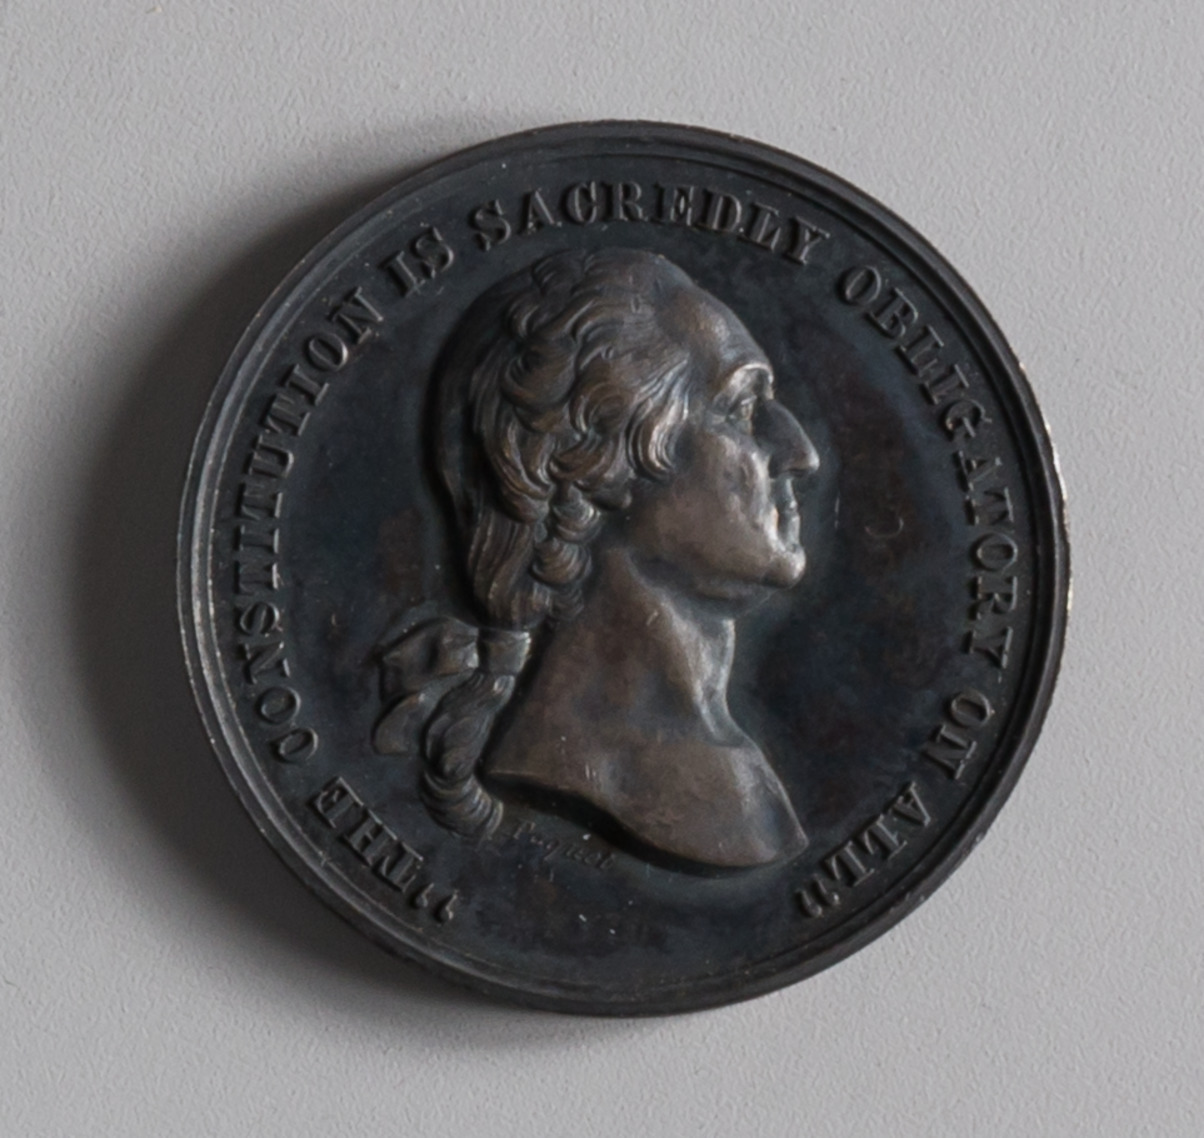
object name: medal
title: George Washington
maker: anthony paquet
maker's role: maker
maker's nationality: american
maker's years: 1814-1882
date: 1861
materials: metal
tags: george washington,profiles